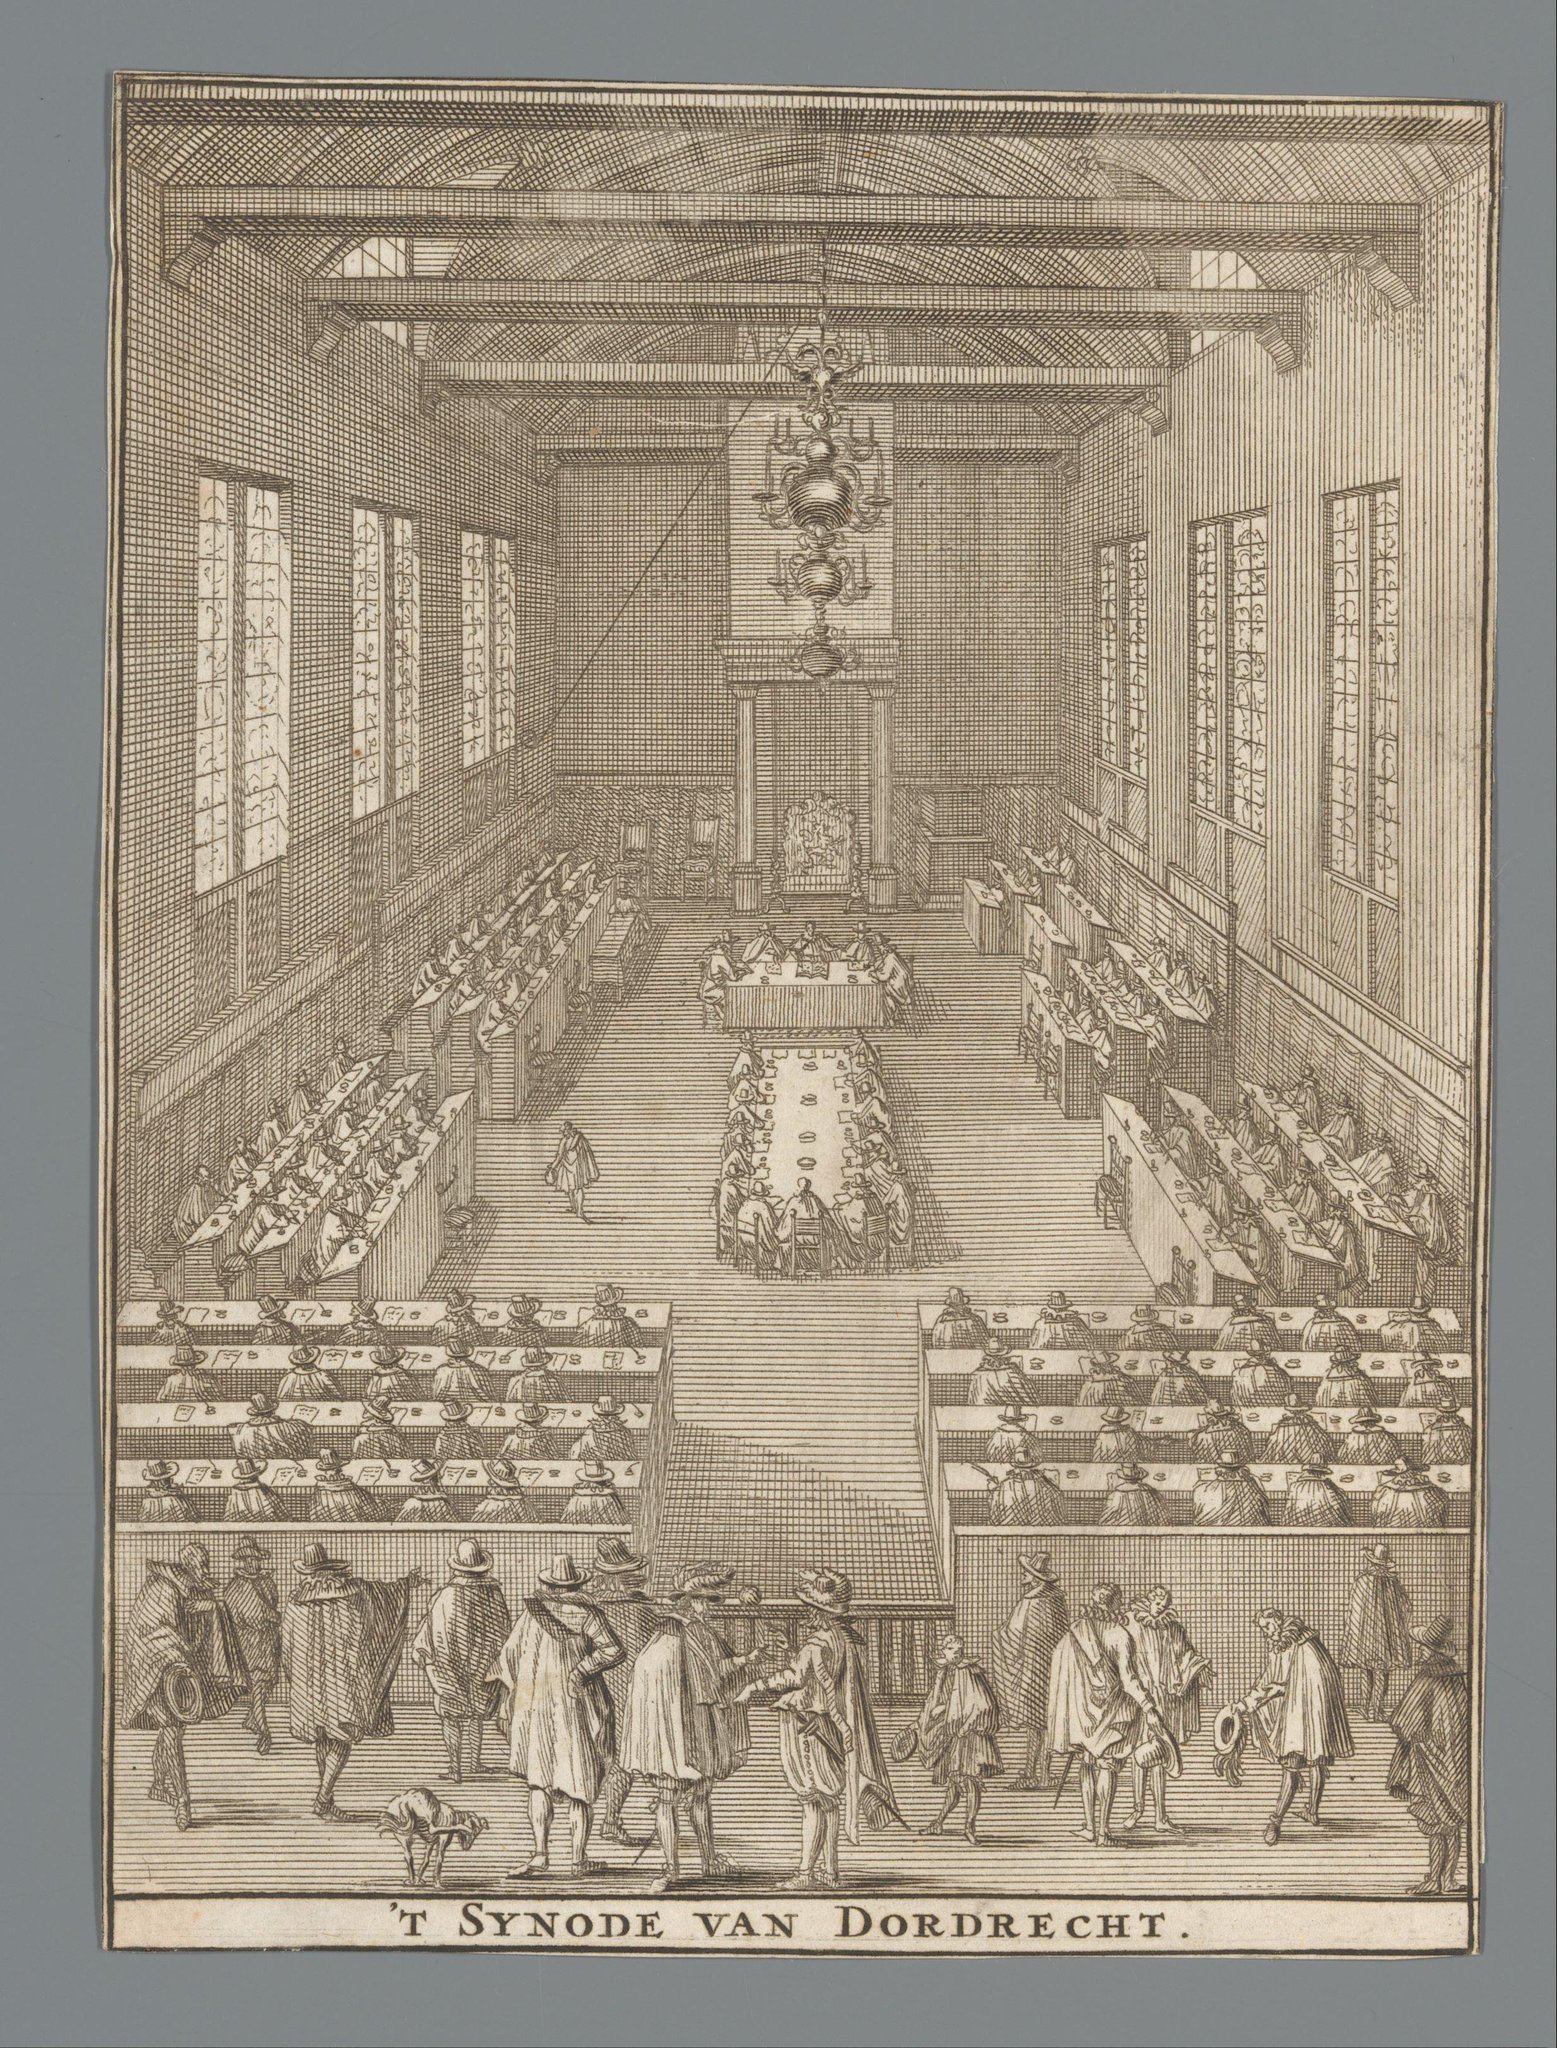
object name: print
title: Opening van de synode van Dordrecht, 1618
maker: Anonymous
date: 1619-1670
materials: paper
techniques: etching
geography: low countries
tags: organizations, assemblies, etc. in protestant churches, political meeting, propaganda meeting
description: De opening van de nationale synode te Dordrecht op 13 november 1618. Gezicht in de grote zaal van de Kloveniersdoelen met alle aanwezigen en toeschouwers.